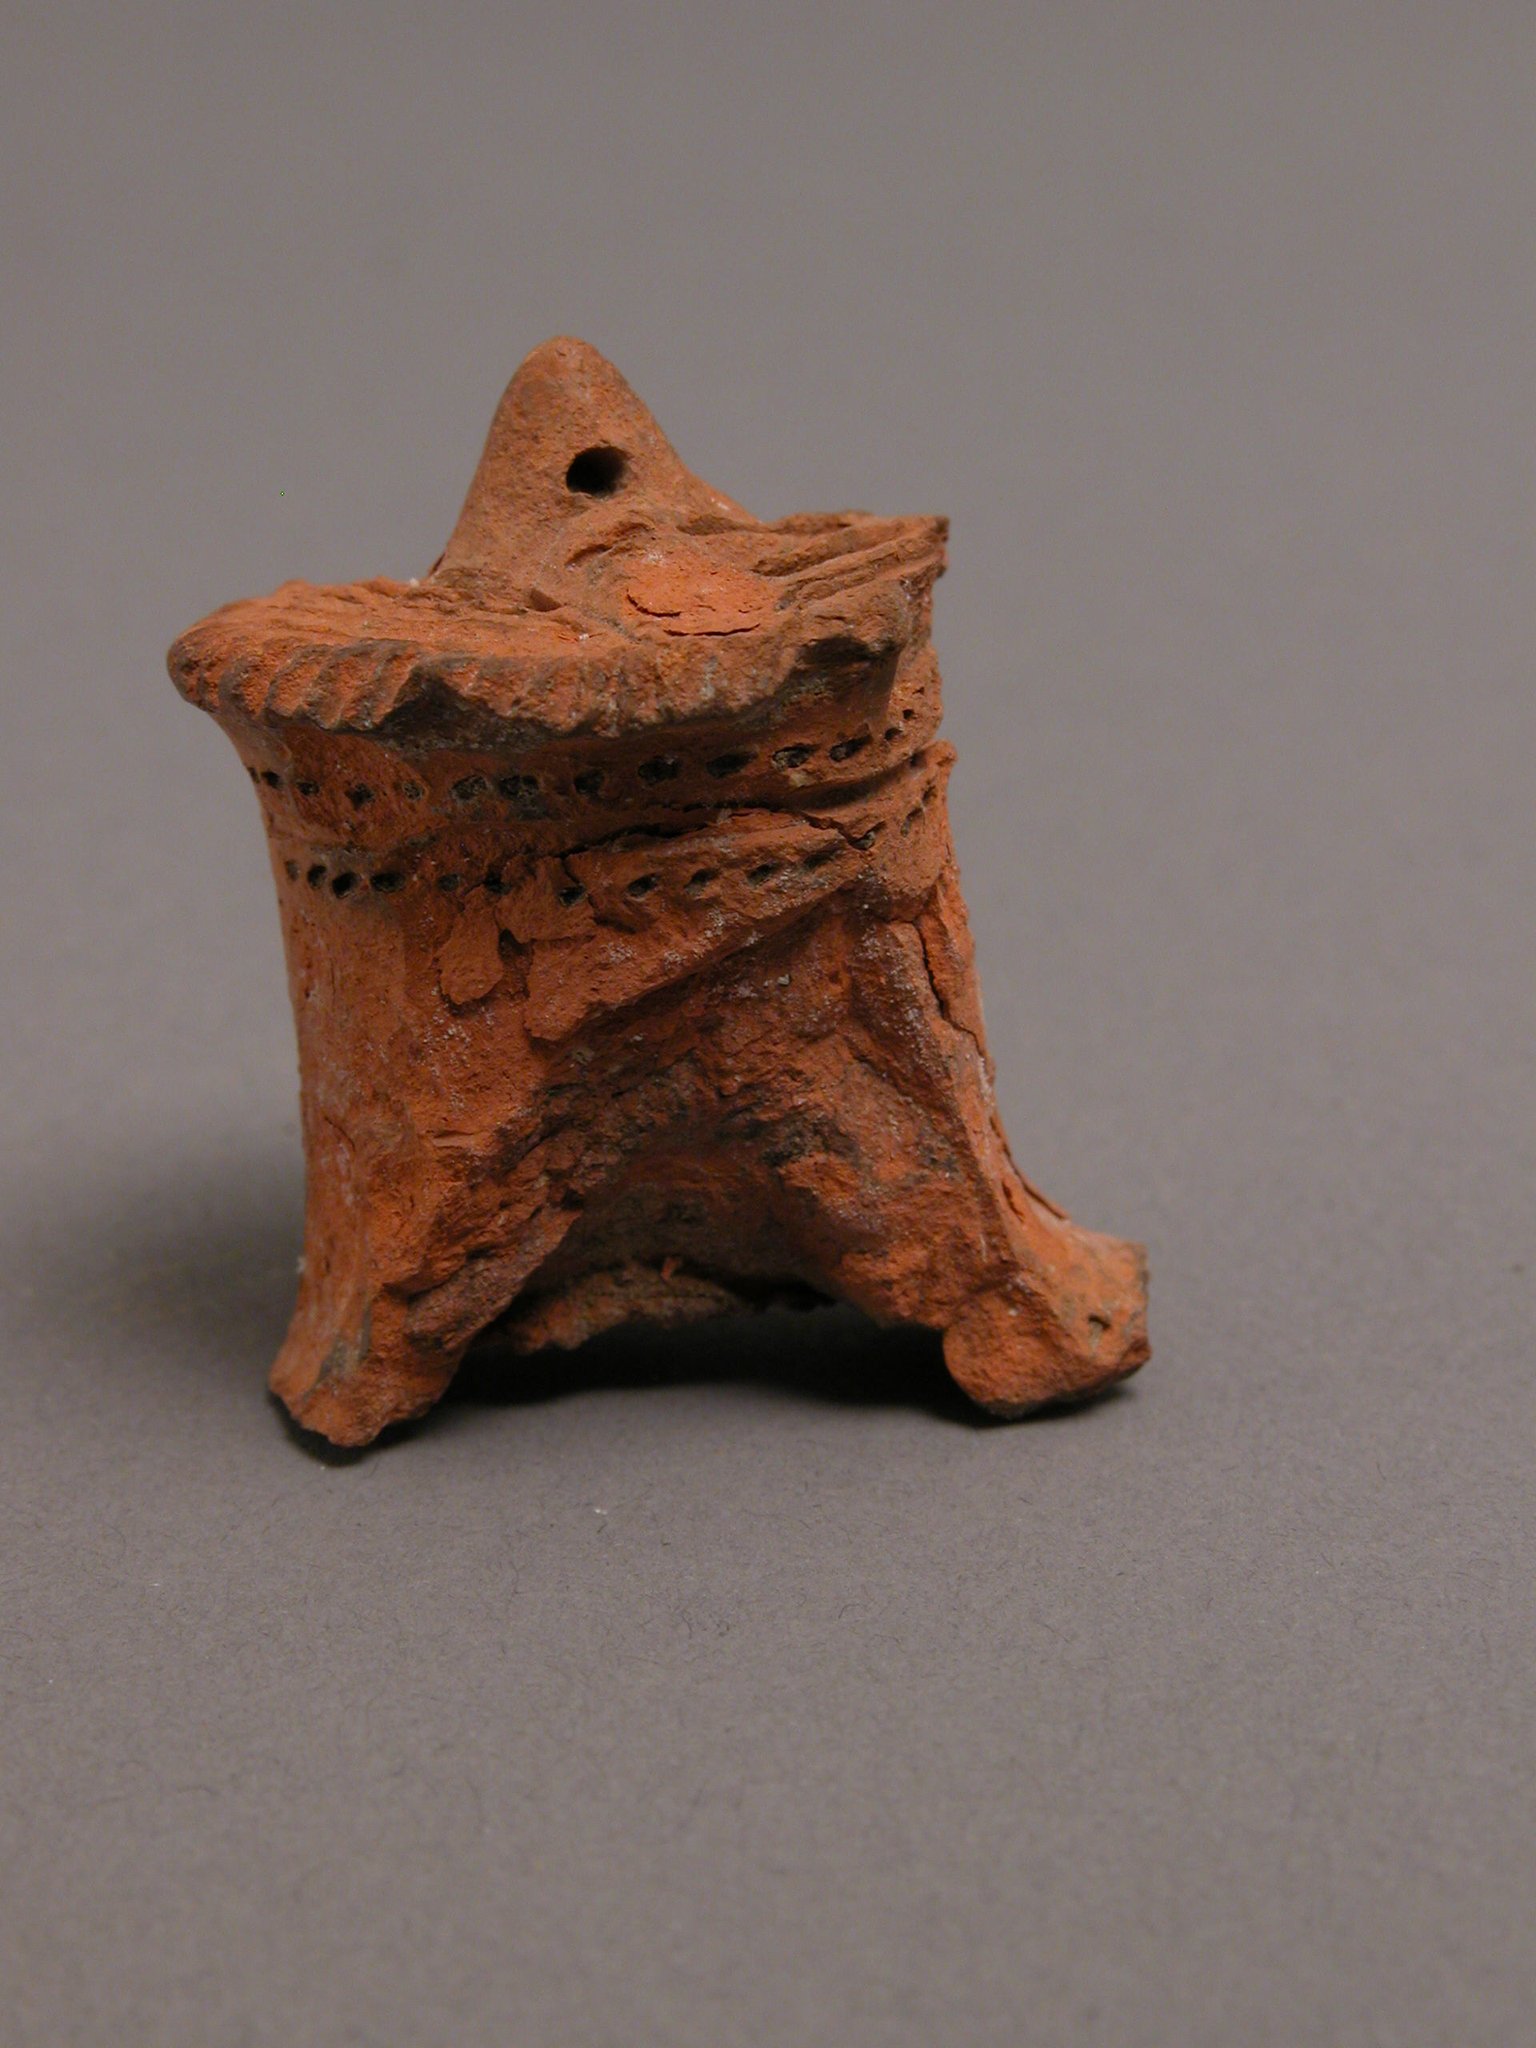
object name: statuette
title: Head Fragment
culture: coptic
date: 301-700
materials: earthenware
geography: egypt